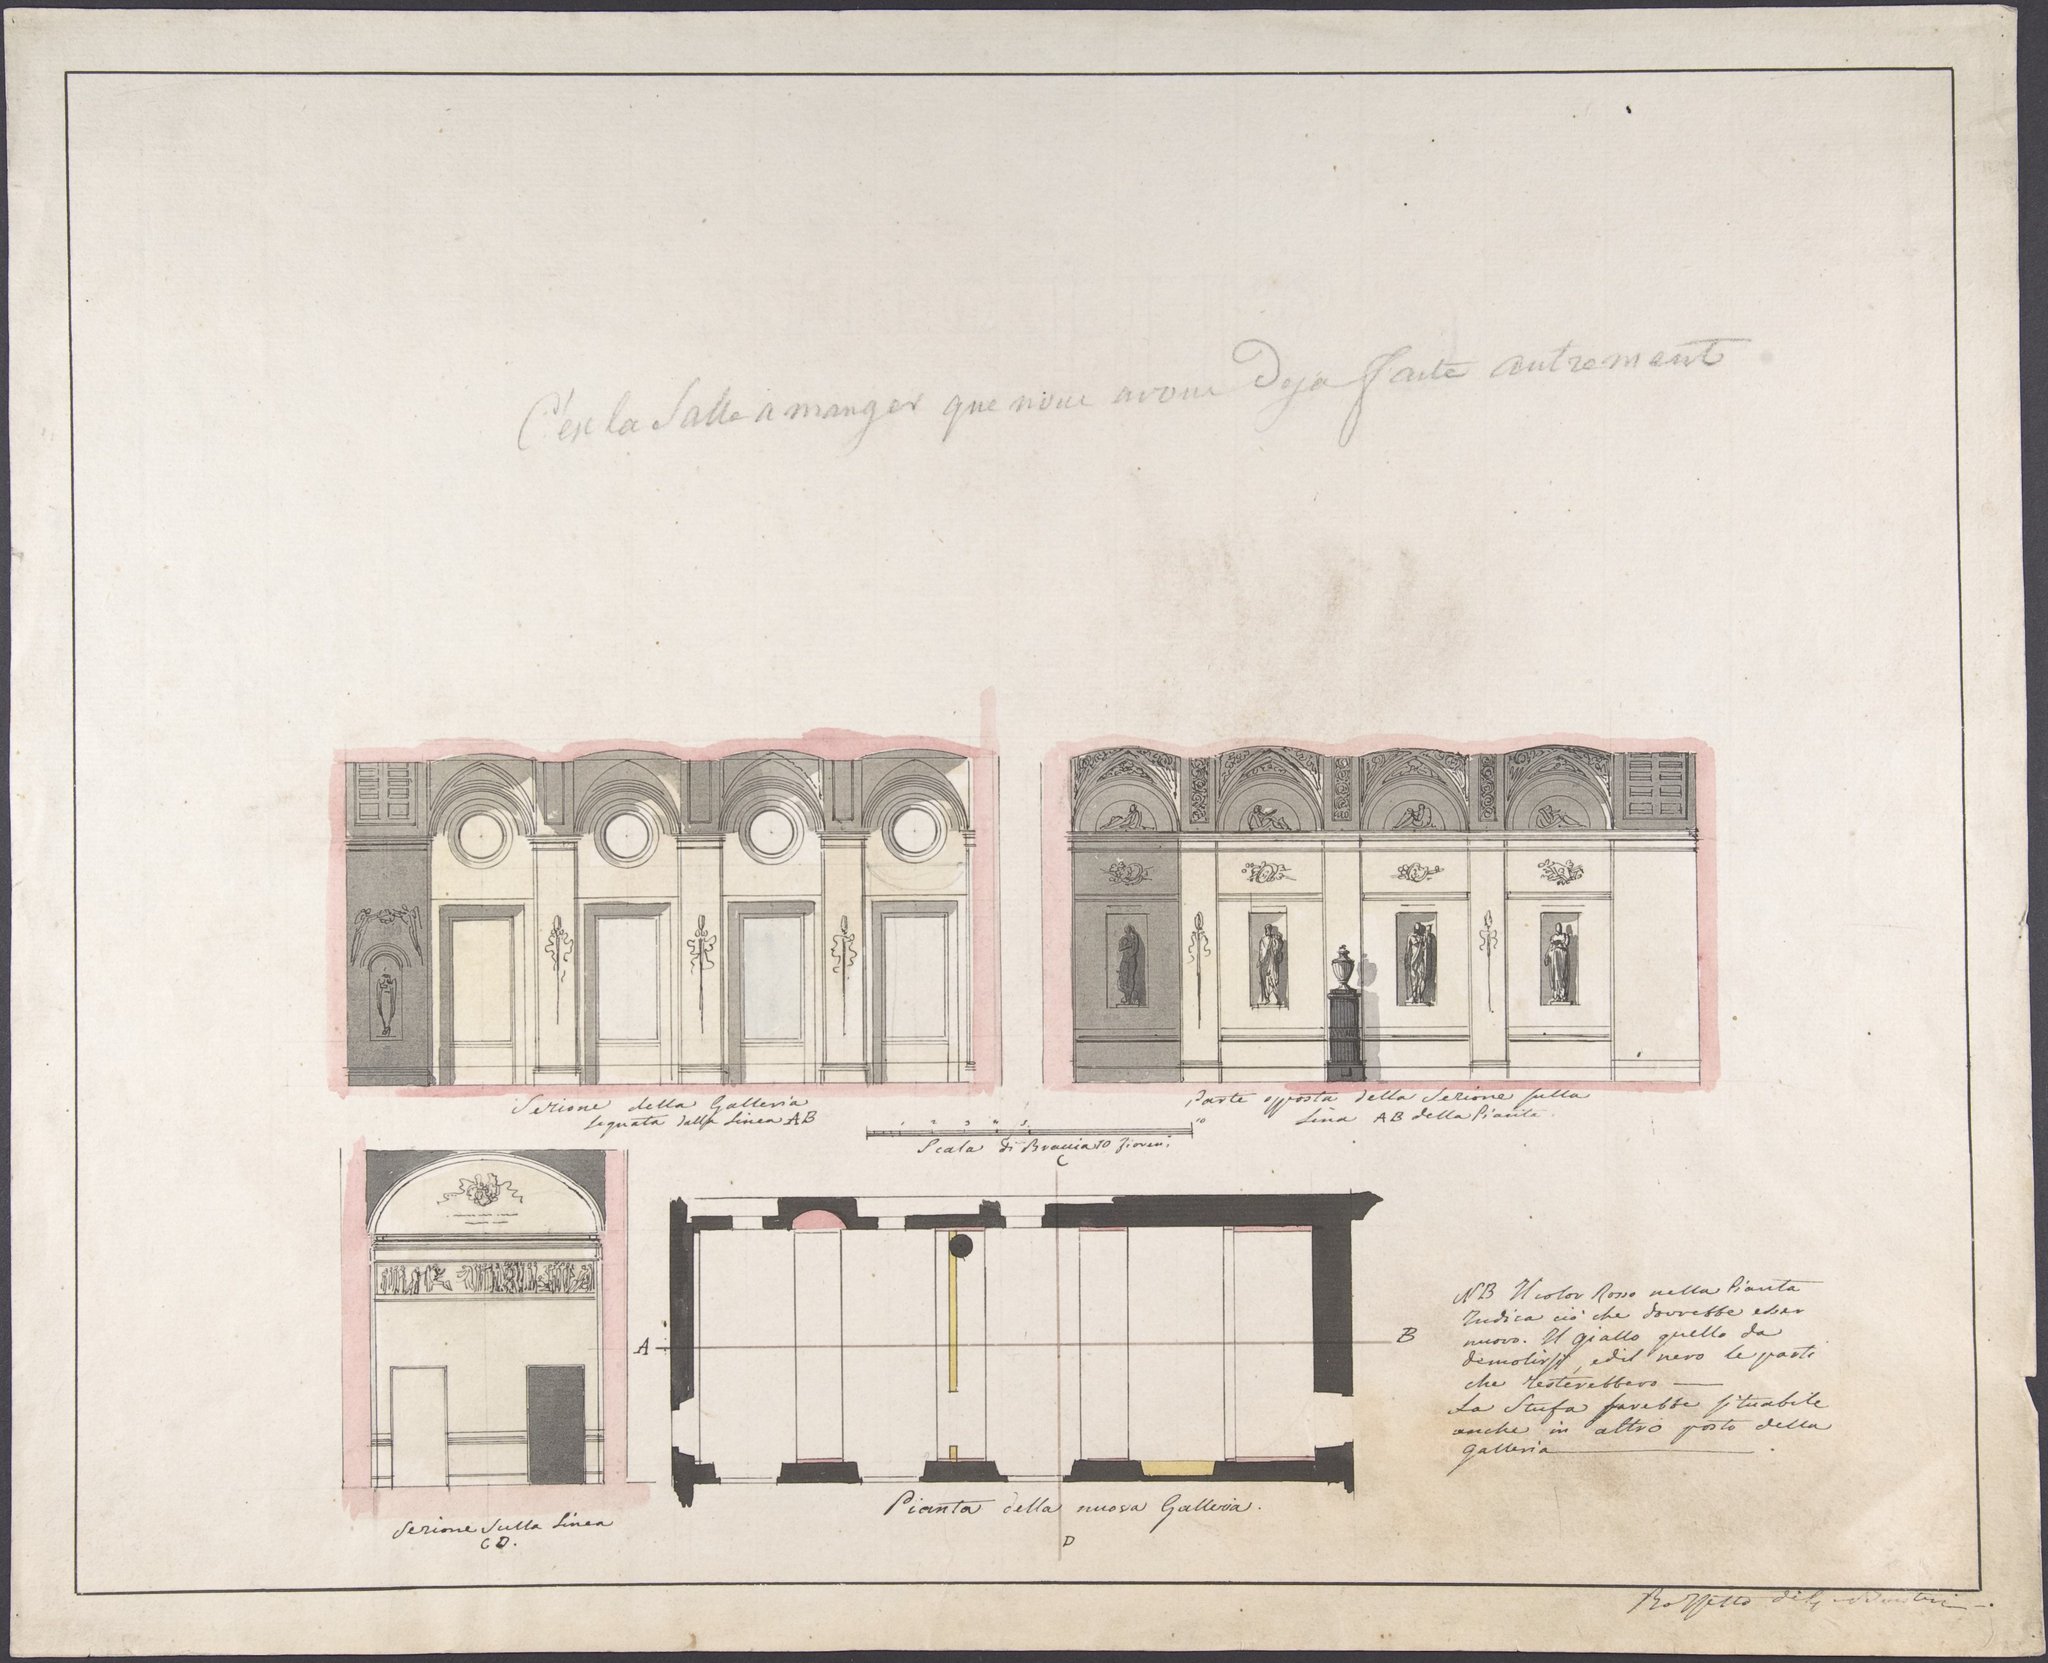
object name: drawing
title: Plan "della nuova Galleria"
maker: giovanni battista silvestri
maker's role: artist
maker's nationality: italian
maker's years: 1796-1873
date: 1796-1873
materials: ink, paper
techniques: pen, wash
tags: architecture